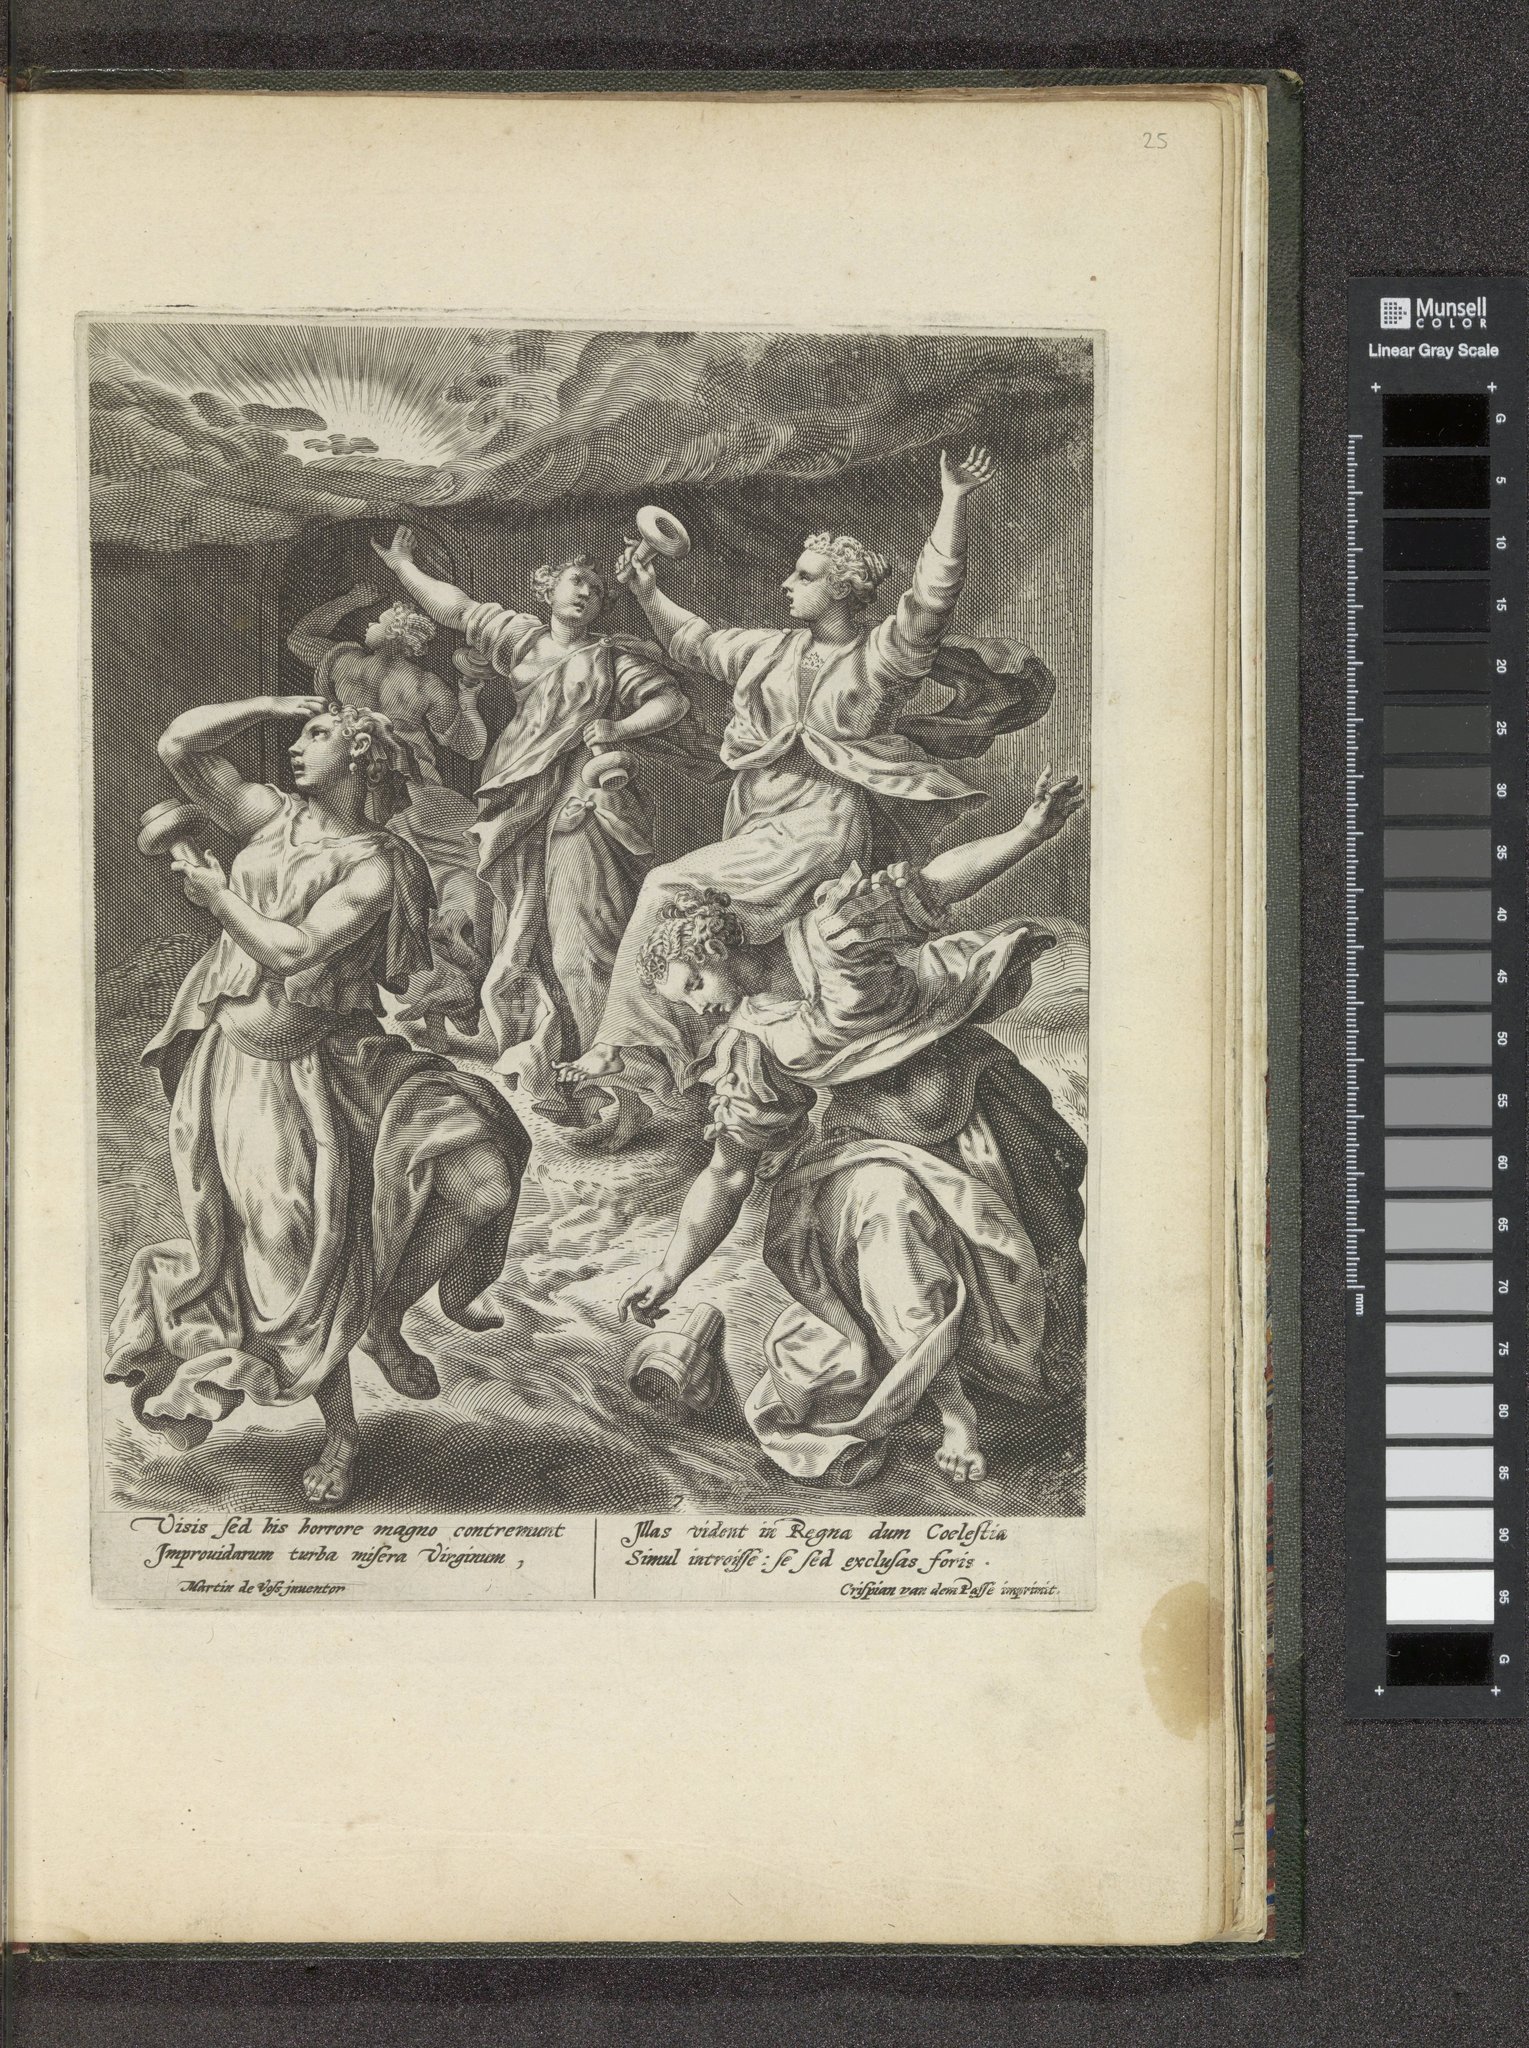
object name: print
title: De vijf dwaze maagden zijn buitengesloten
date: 1589-1611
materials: paper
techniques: engraving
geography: cologne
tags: the wise virgins are let into the house with the bridegroom (christ); the foolish virgins are shut out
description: De vijf dwaze maagden staan voor de gesloten deur van het huis van de bruidegom. Ze roepen om binnengelaten te worden. In de marge een vierregelig onderschrift, in twee kolommen, in het Latijn dat verwijst naar de buitengesloten maagden. Deze prent maakt deel uit van een album.